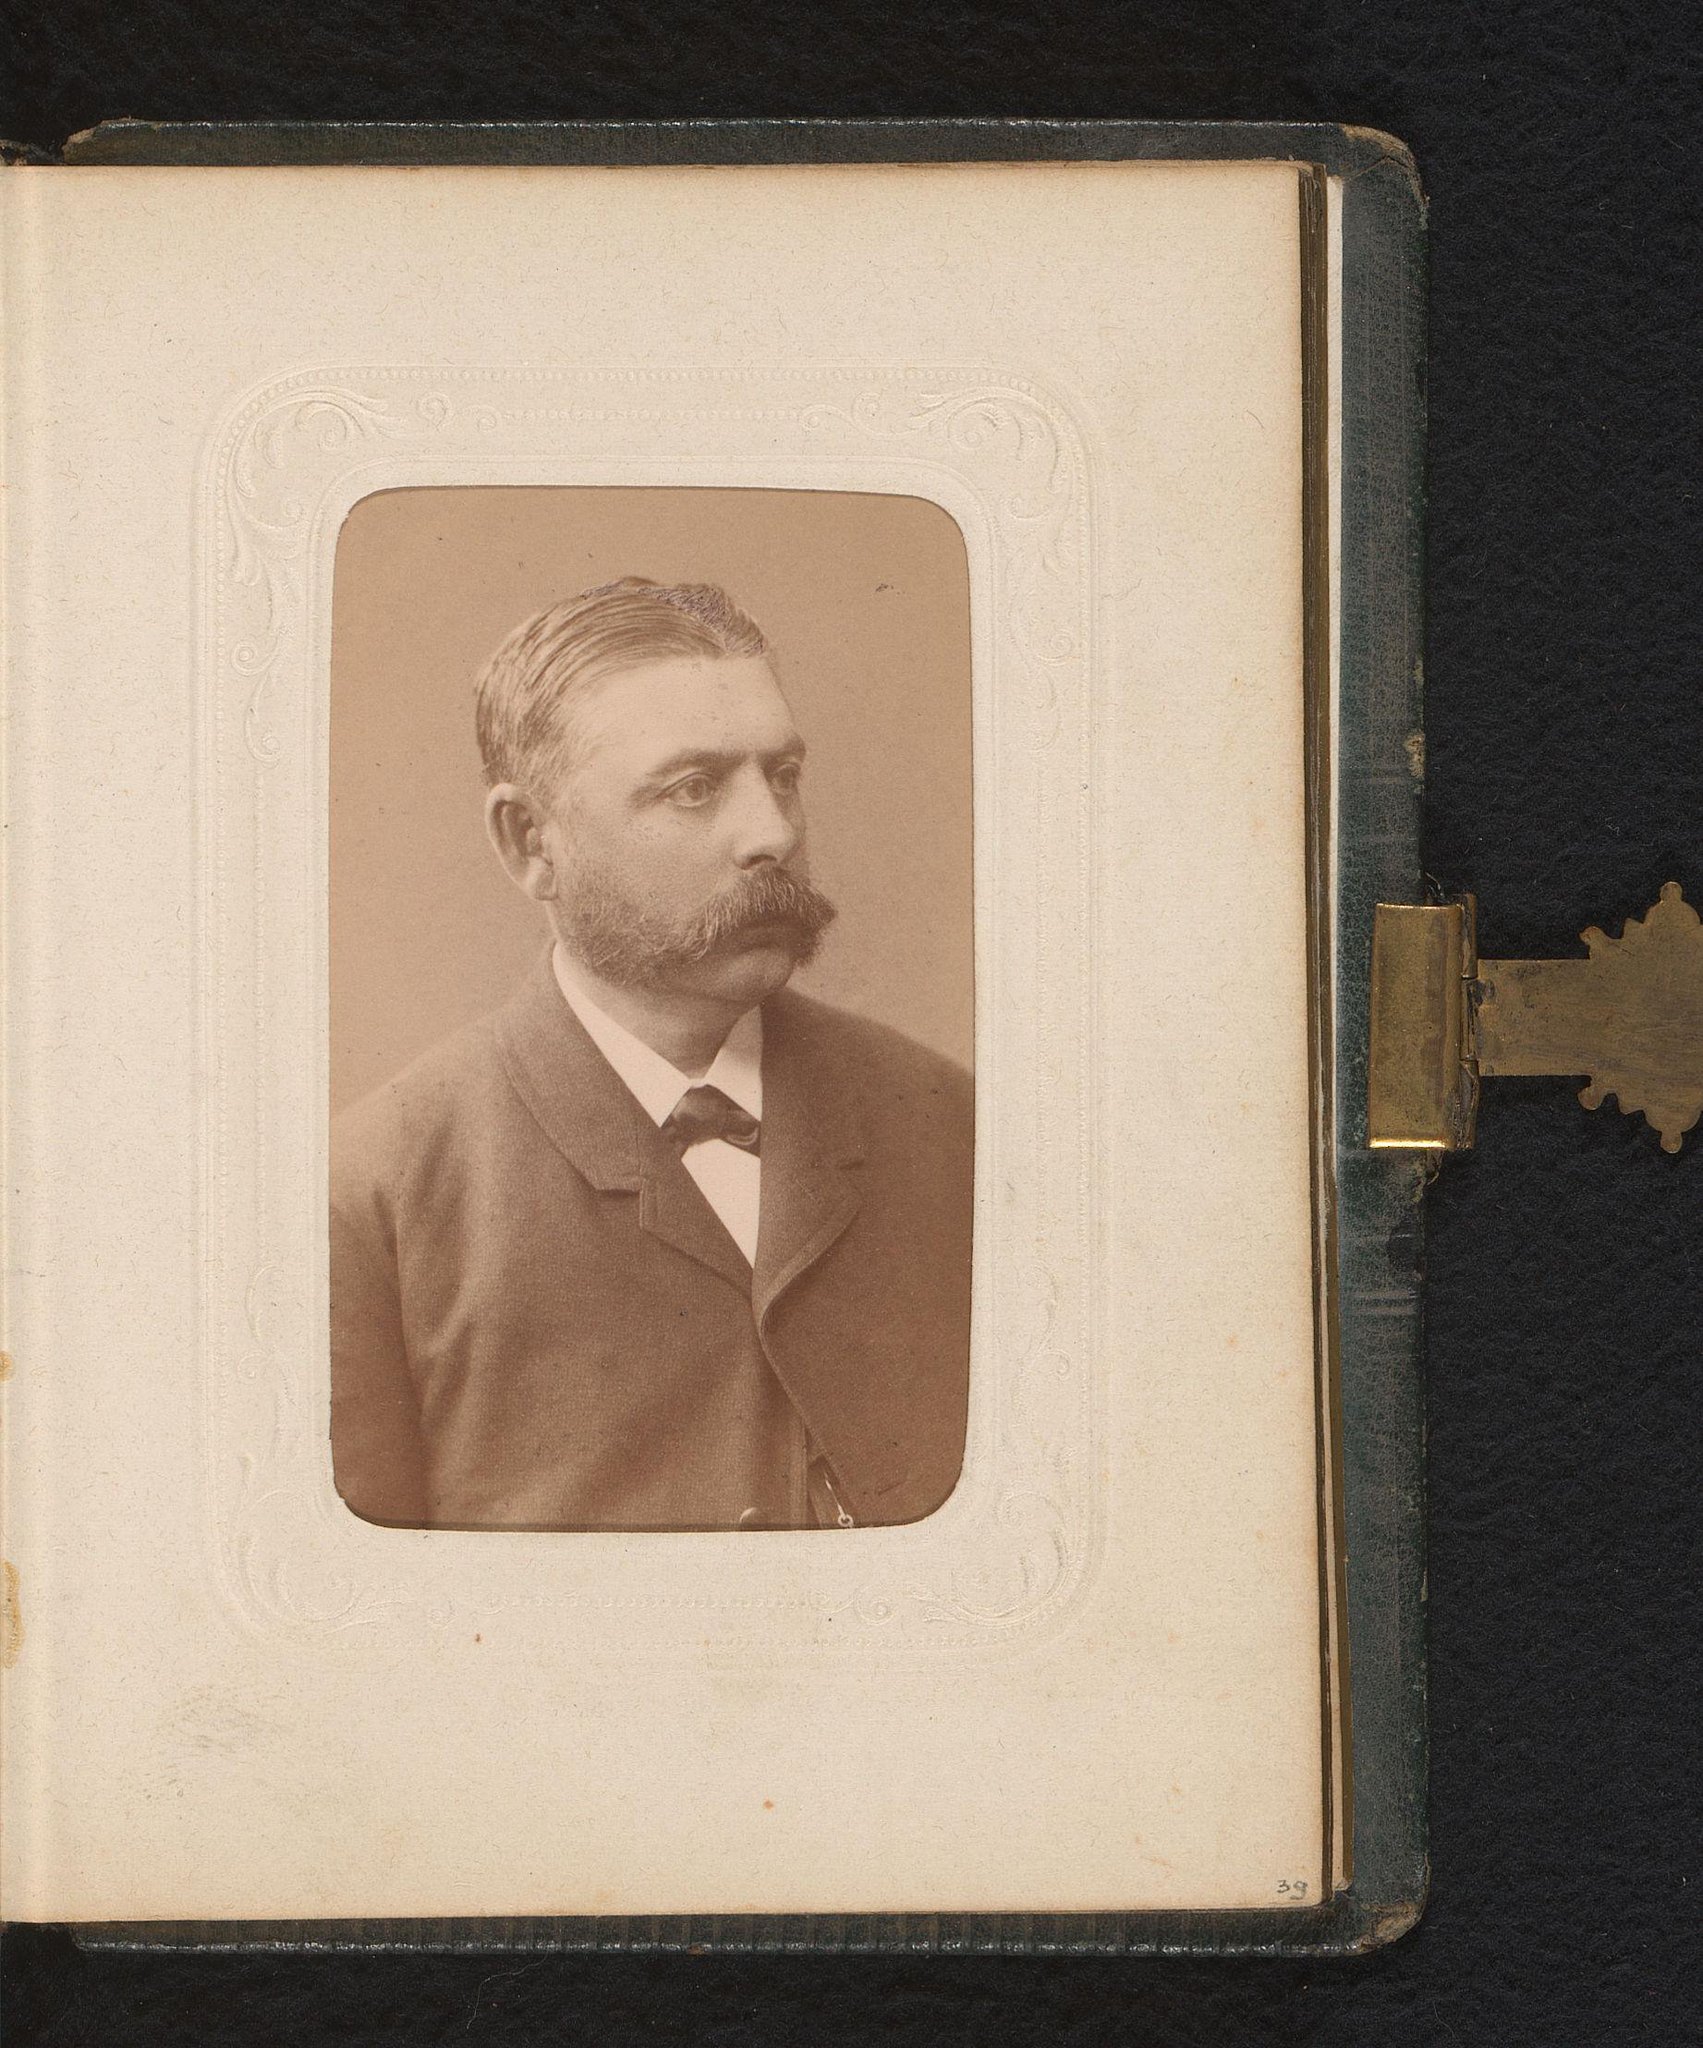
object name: photograph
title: Portret van een man met snor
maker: waldemar dahllöf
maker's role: fotograaf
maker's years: 1844-1935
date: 1860-1900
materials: cardboard, photographic support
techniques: albumen print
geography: göteborg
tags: moustache, historical persons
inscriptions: inscription: ‘Wald. Dahllöf/ GÖTEBORG/ Östra Hamngatan No. 18./ Första Ateliern 83, Lorensbergsgatan 83/ Plåten behälles för efterbeställning’